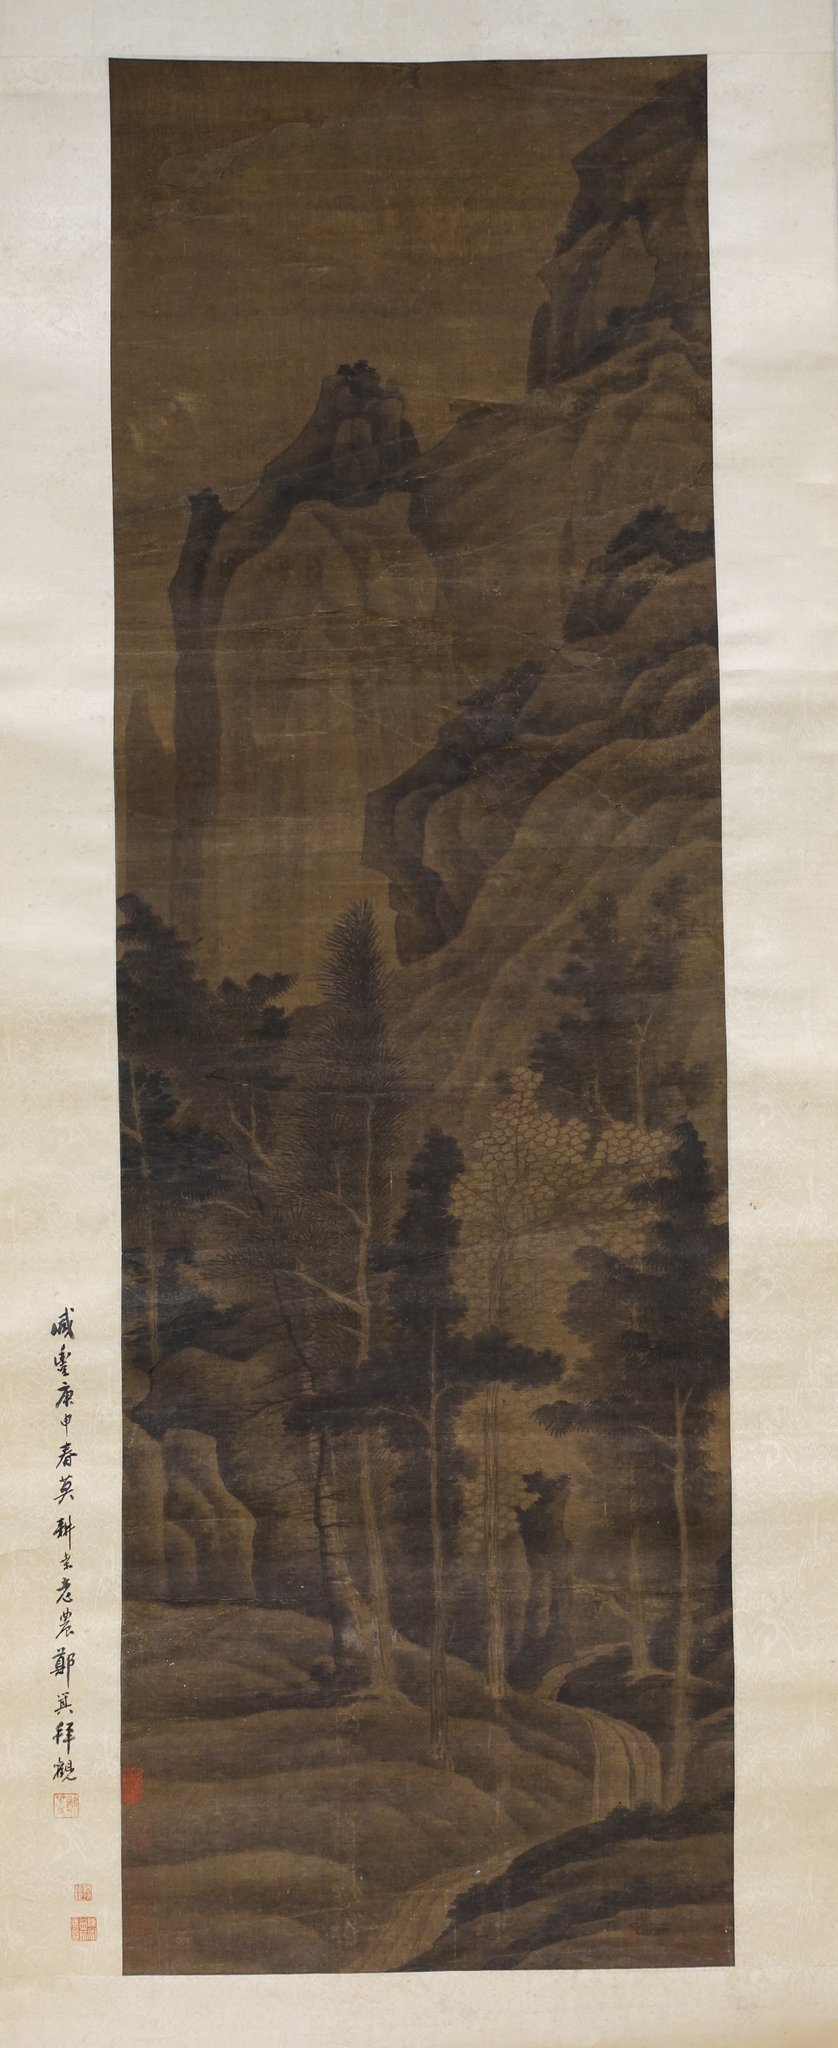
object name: hanging scroll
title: Mountain Landscape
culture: chinese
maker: unidentified artist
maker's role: artist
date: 1368-1911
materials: ink, silk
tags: mountains,landscapes